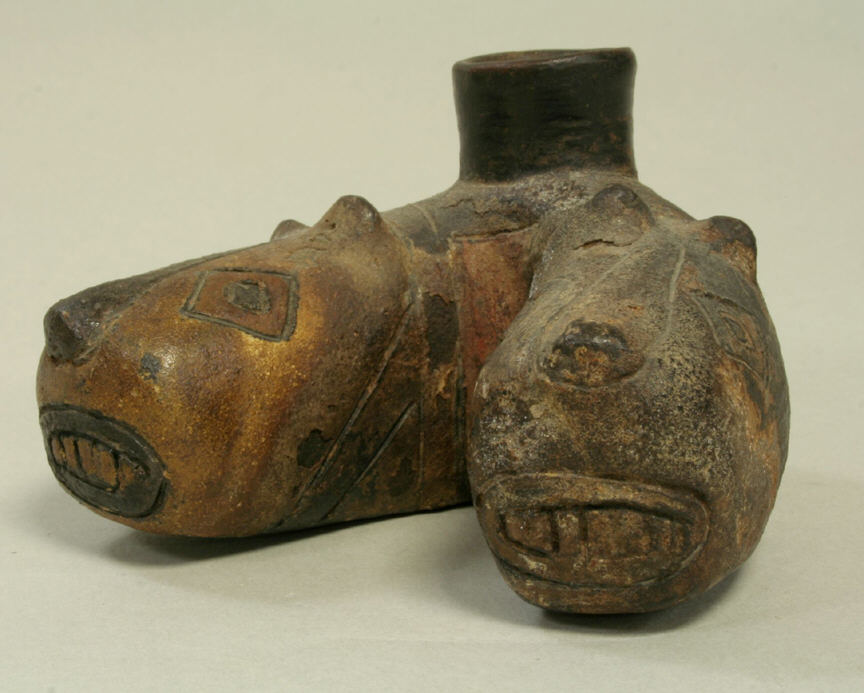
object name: vessel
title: Spouted Vessel with Double Headed Snake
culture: paracas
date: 500-301 BCE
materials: ceramic, paint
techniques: firing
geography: peru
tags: snakes